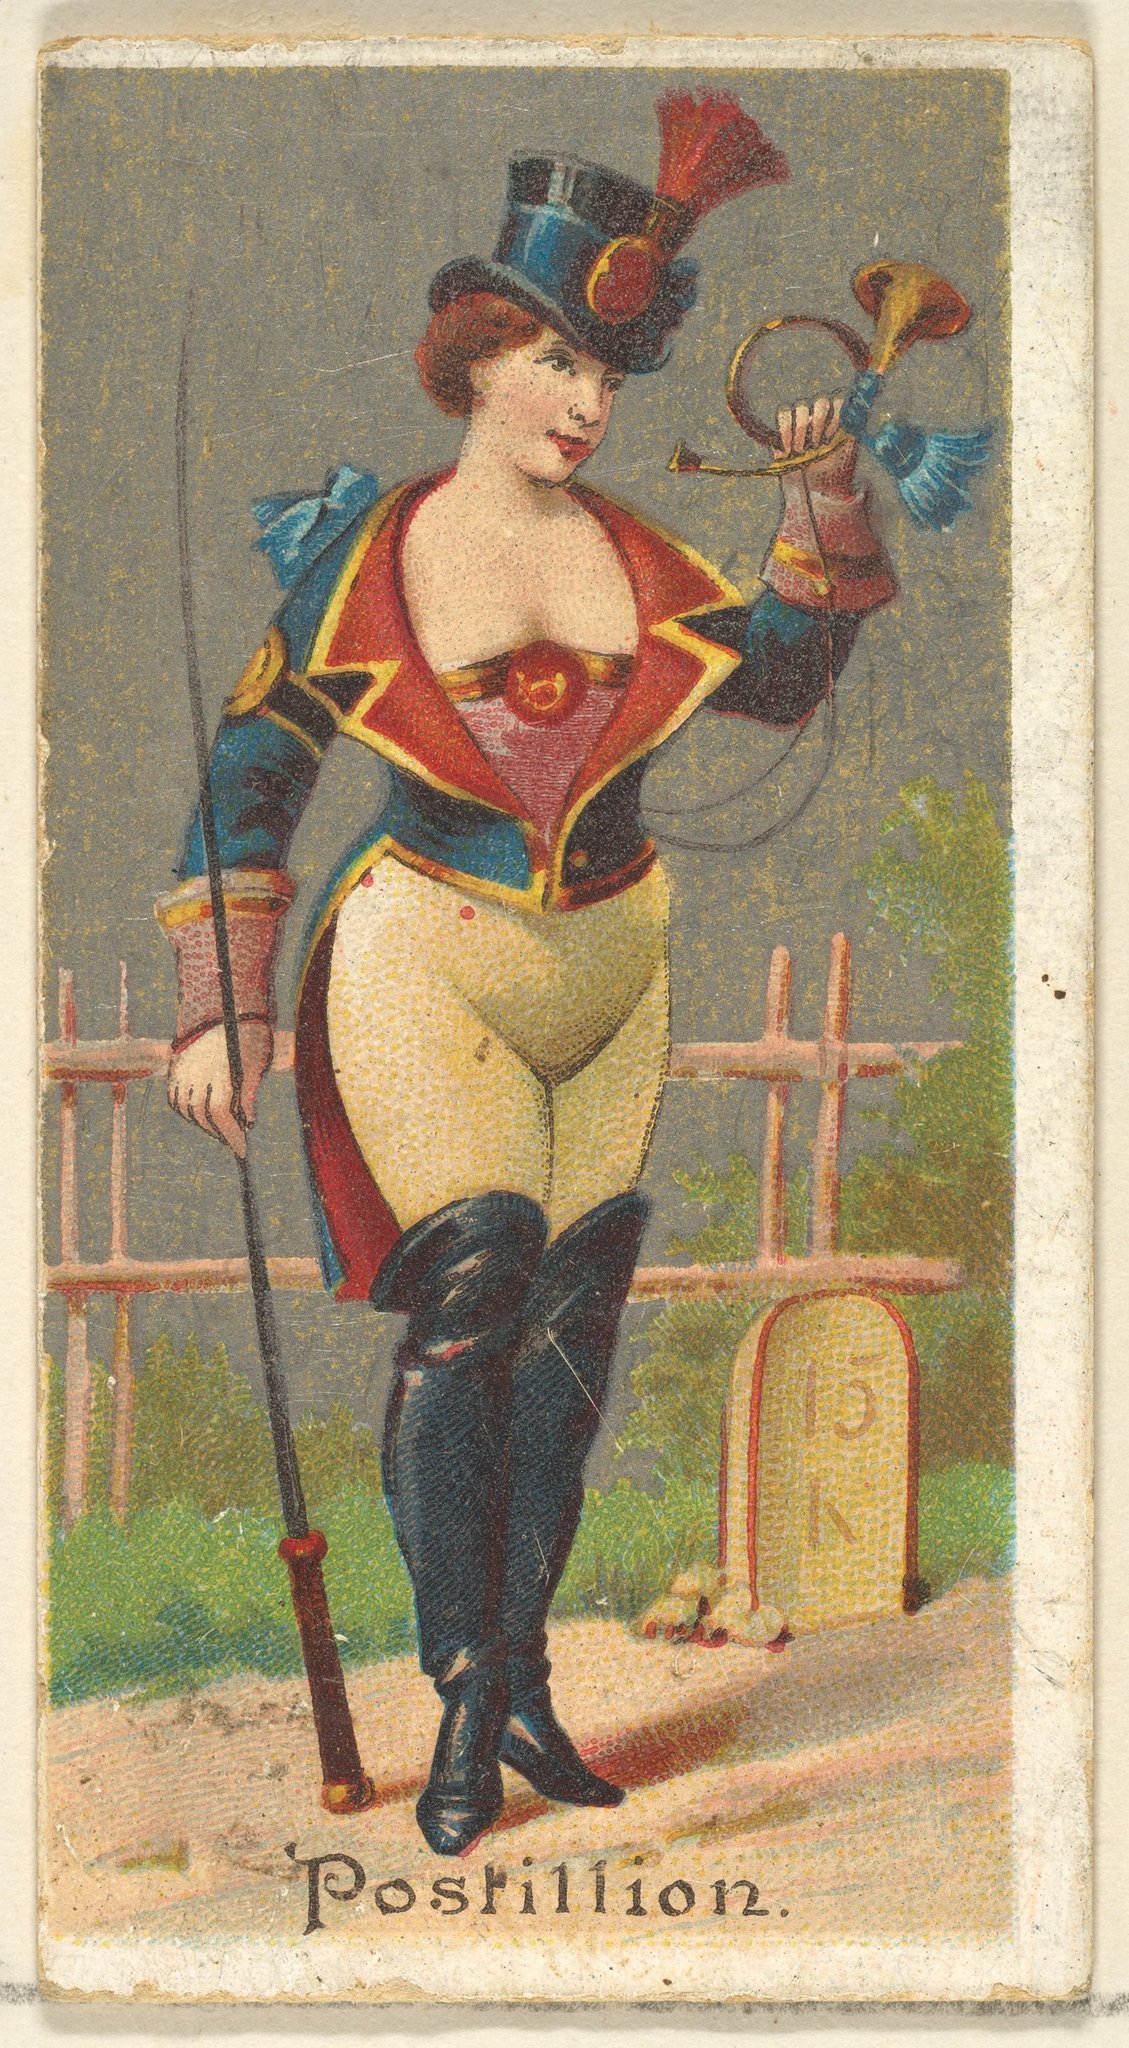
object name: print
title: Postillion, from the Occupations for Women series (N166) for Old Judge and Dogs Head Cigarettes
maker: goodwin & company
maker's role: publisher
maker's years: 1850-1950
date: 1887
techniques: color lithograph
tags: musical instruments,women